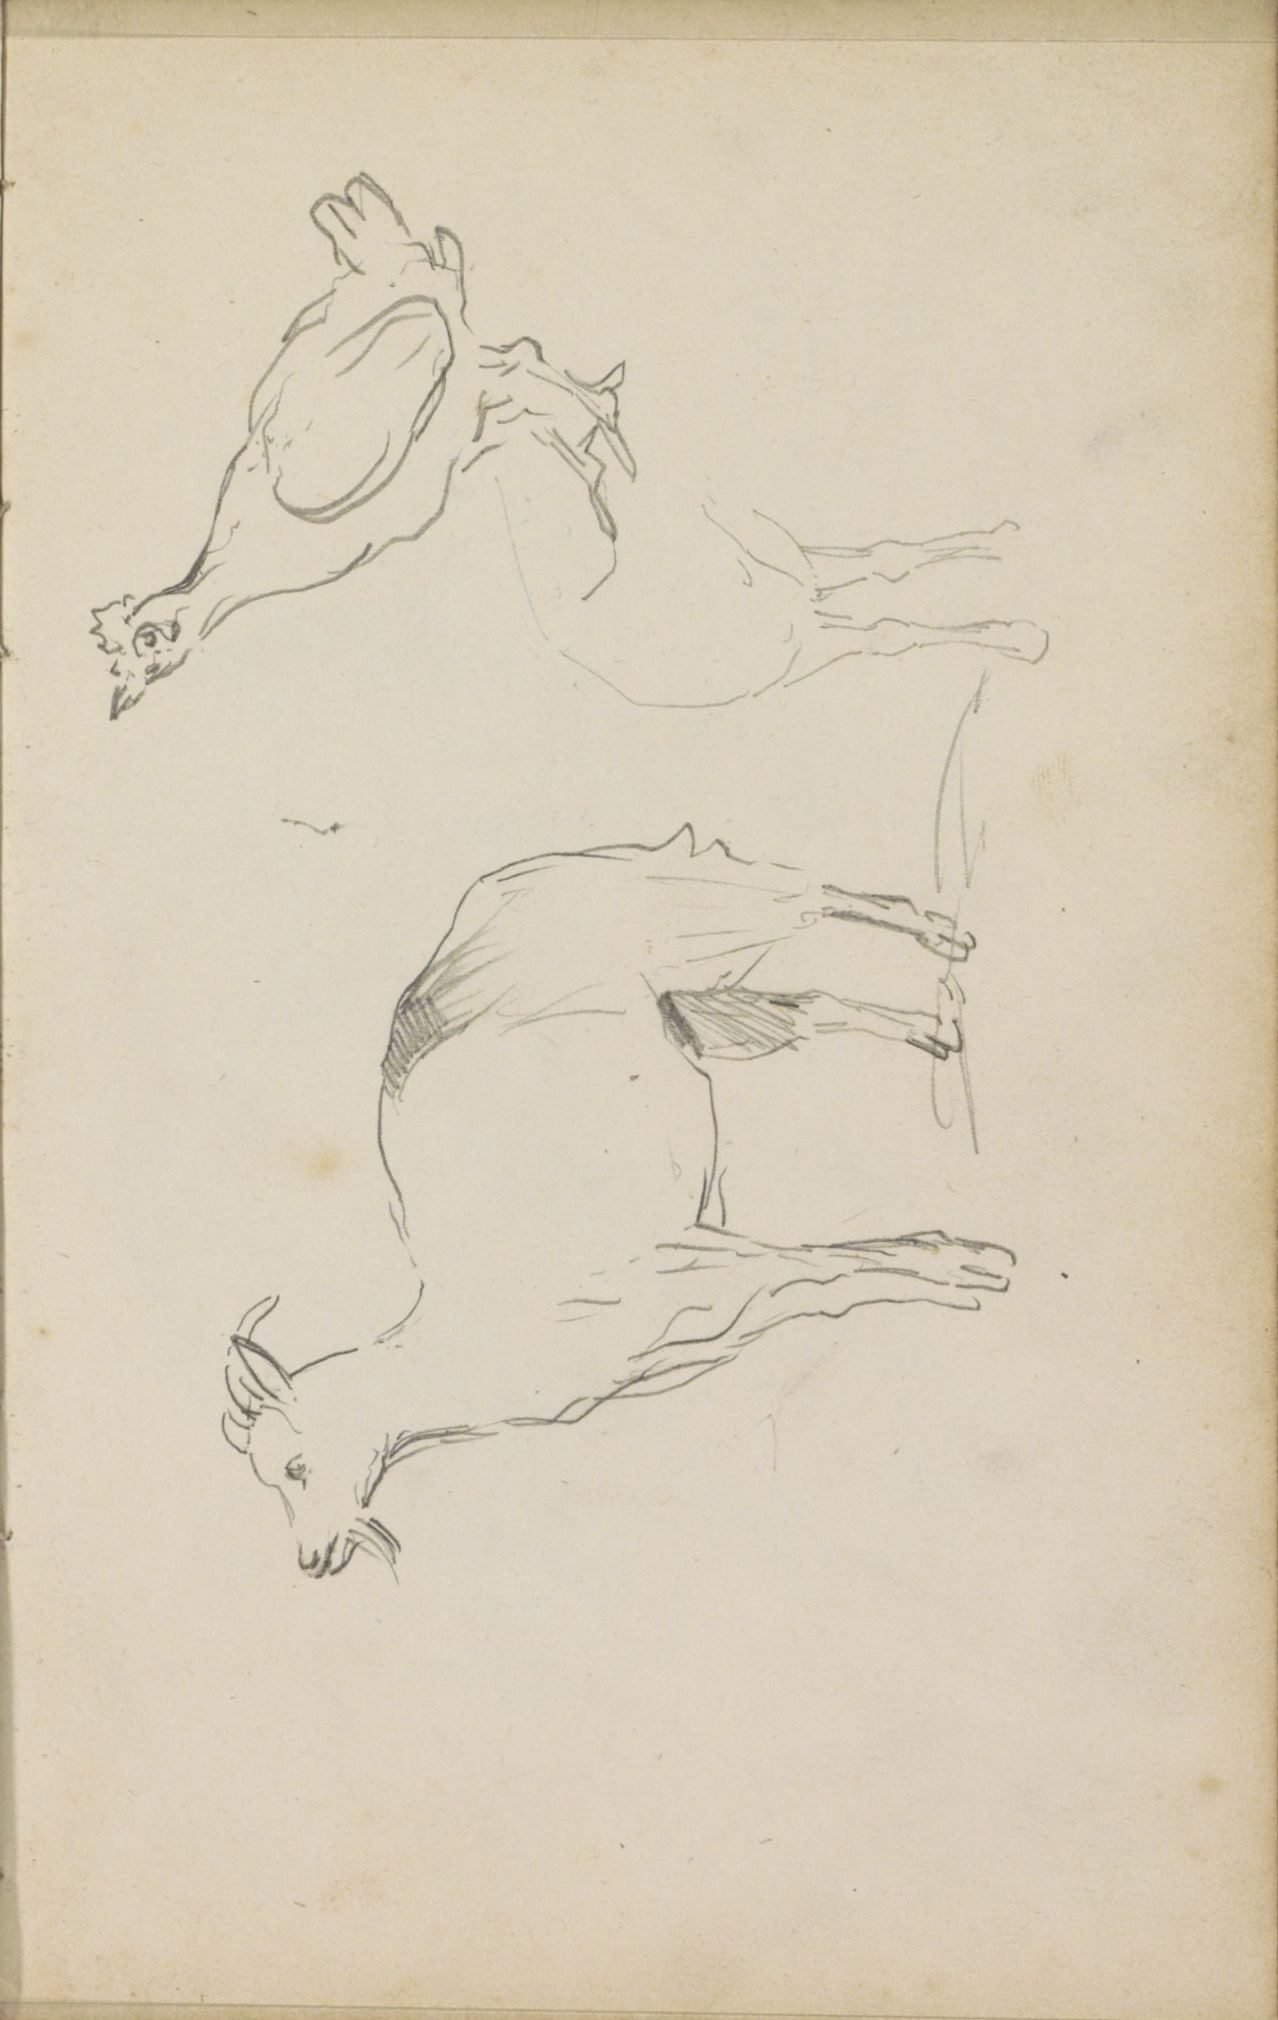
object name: sketchbook leaf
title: Geit en een kip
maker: johannes tavenraat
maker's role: draughtsman, painter, print maker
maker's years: 1809-1881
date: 1839-1872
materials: paper, pencil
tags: fowl (cock, hen, chicken, etc.), goat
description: Blad 18 recto uit een schetsboek met 73 bladen.